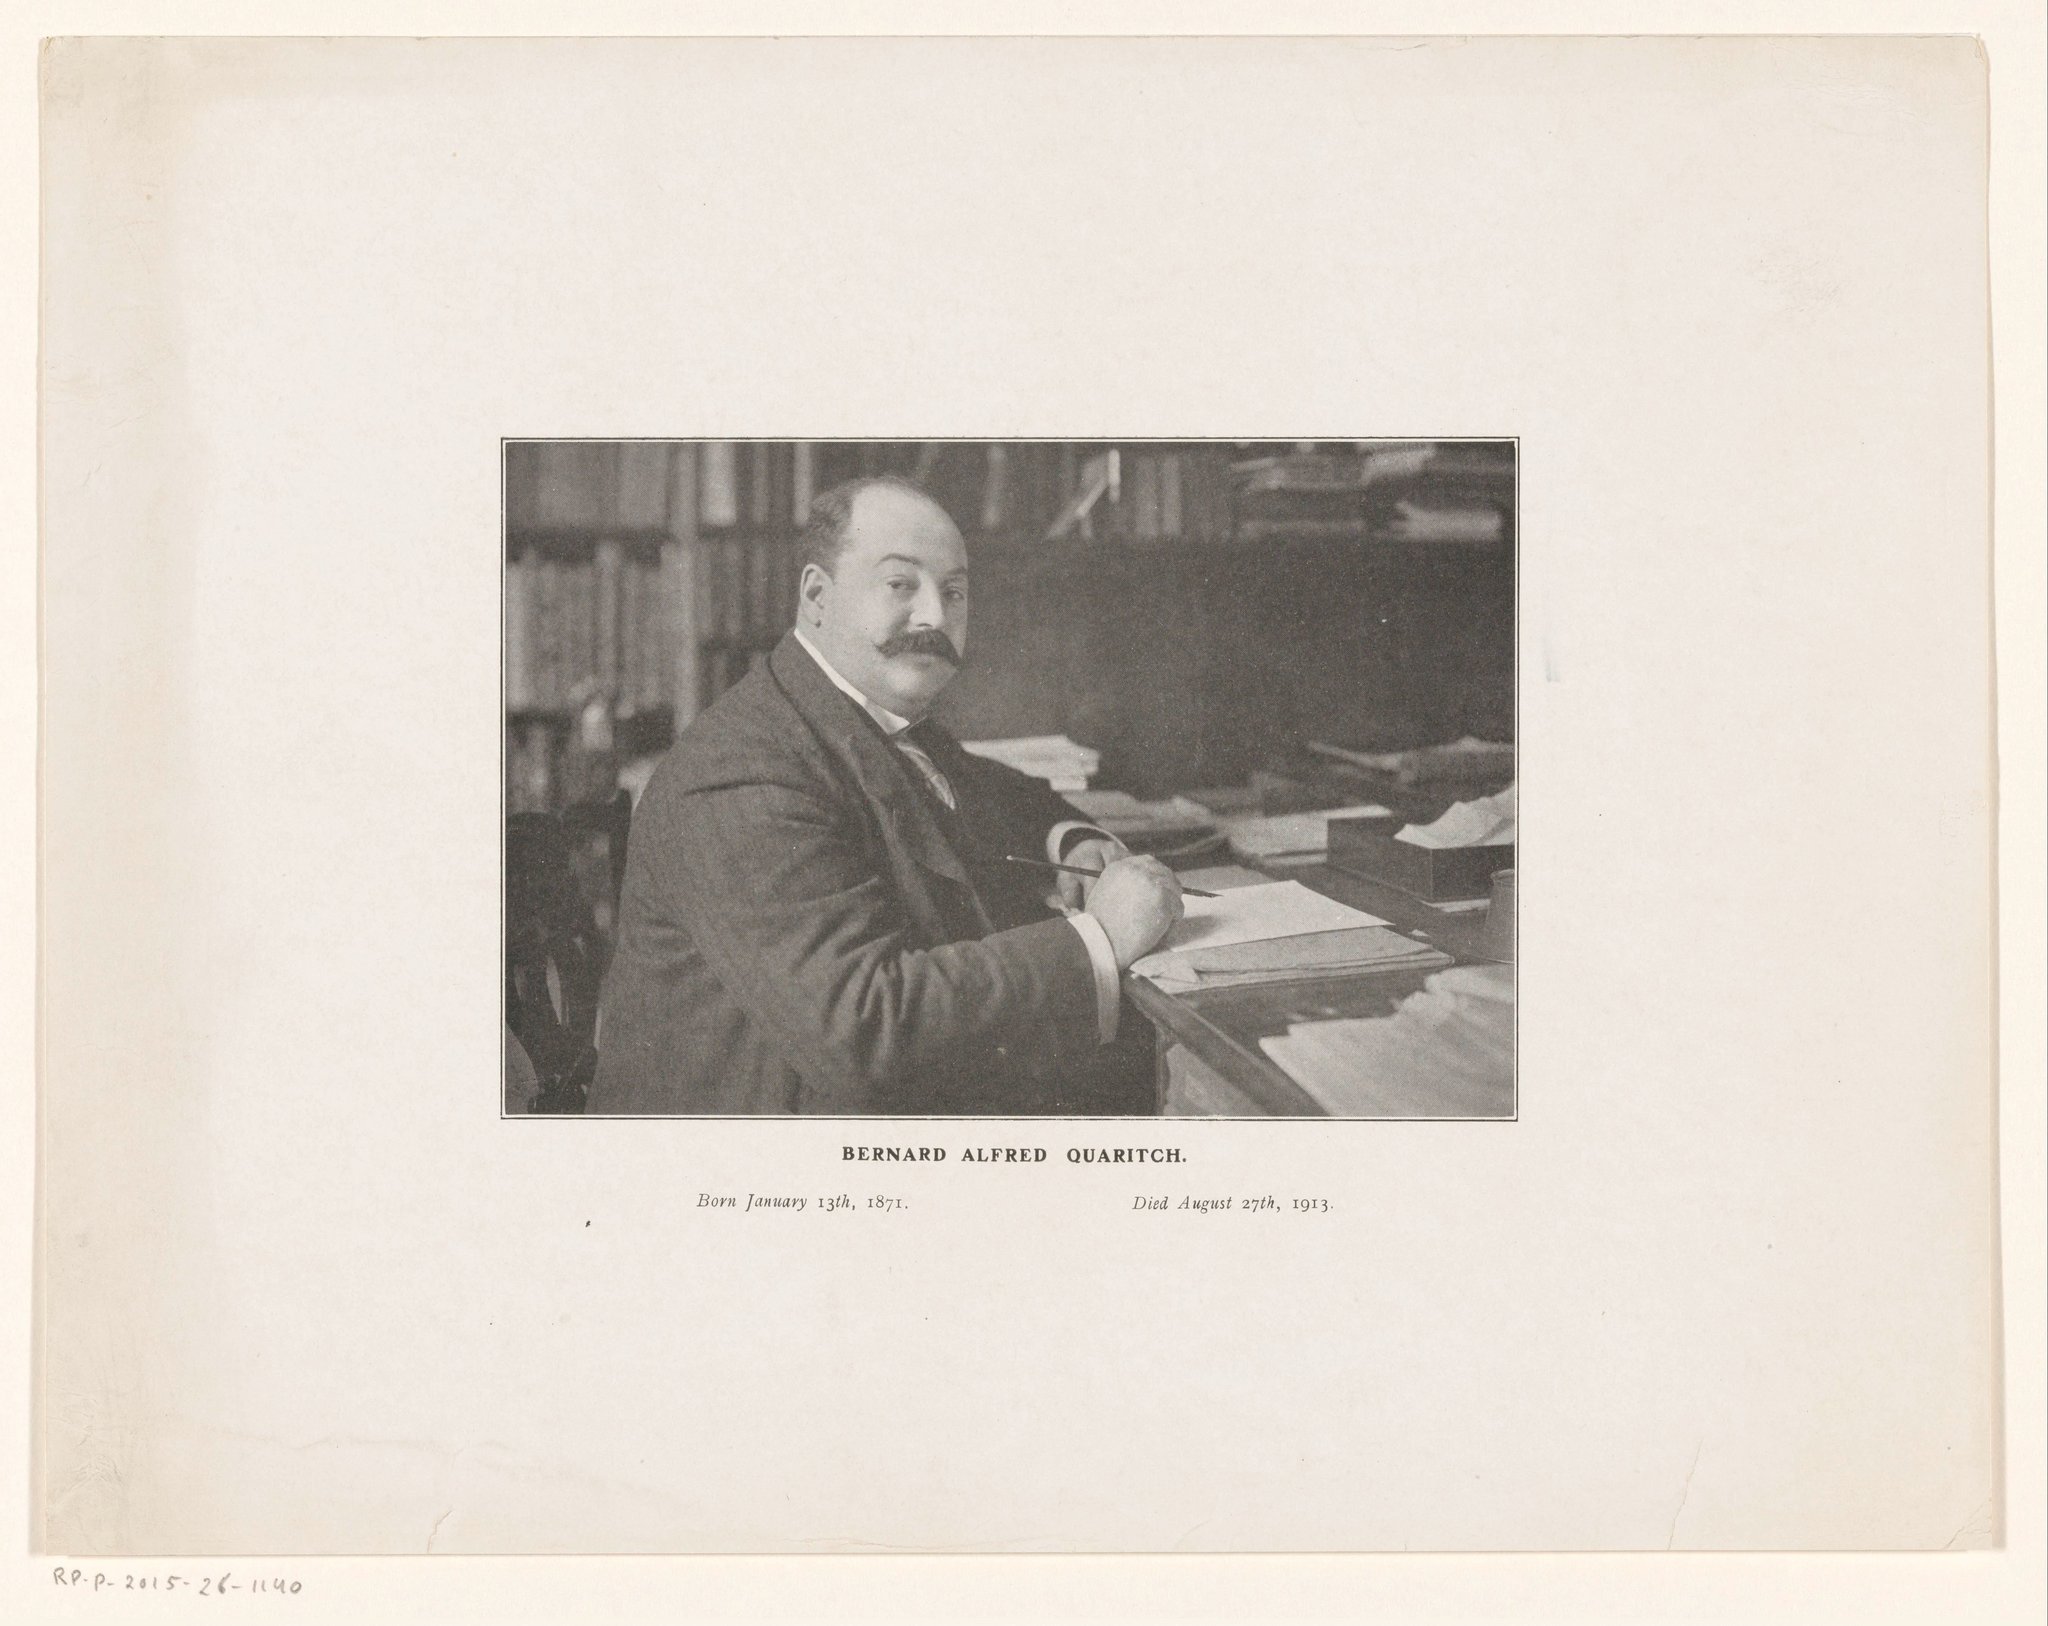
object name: photograph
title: Bernard Alfred Quaritch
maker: Anonymous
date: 1913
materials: paper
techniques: printing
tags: book-shop, bookseller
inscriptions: collector's mark: Lugt 2228